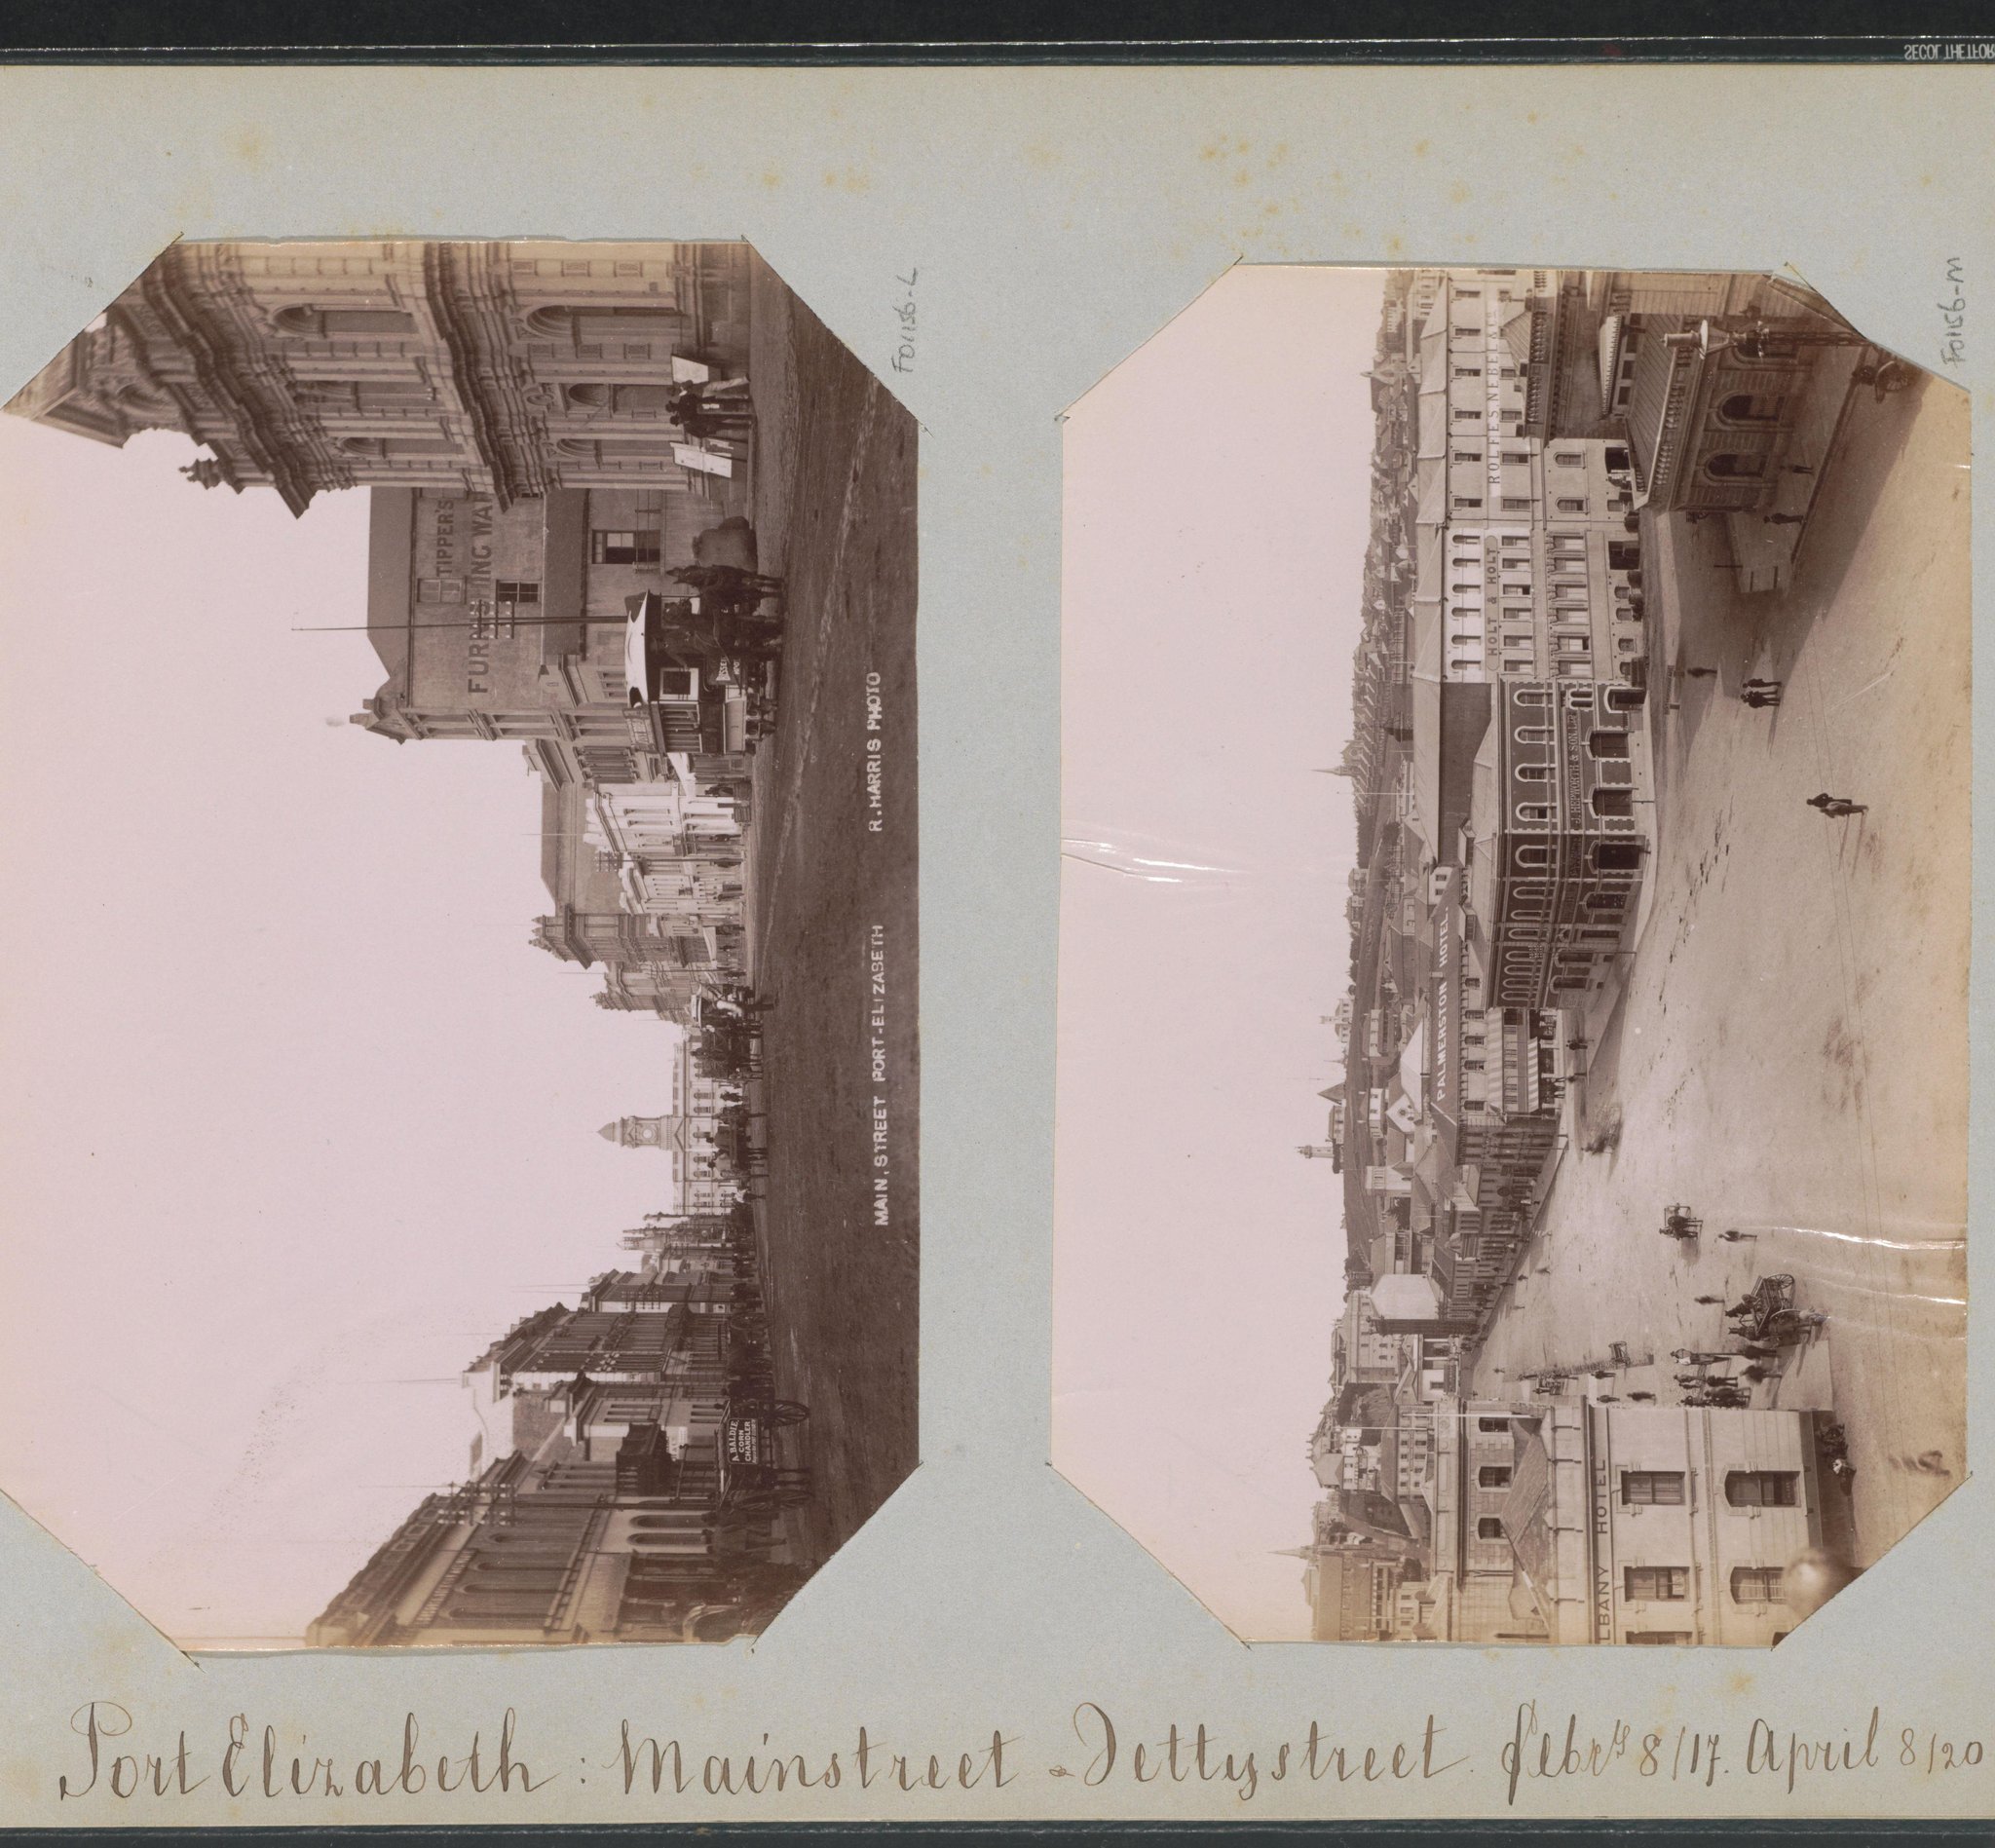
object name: photograph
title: Gezicht op Main Street te Port Elizabeth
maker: robert harris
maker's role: fotograaf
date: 1880-1894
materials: photographic support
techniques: albumen print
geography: port elizabeth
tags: street (+ city(-scape) with figures, staffage)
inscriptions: inscription: ‘Main Street Port-Elizabeth/ R. Harris Photo’, annotation: ‘Port Elizabeth: Mainstreet - Jettystreet febr 8/17. April 8/20 1896’